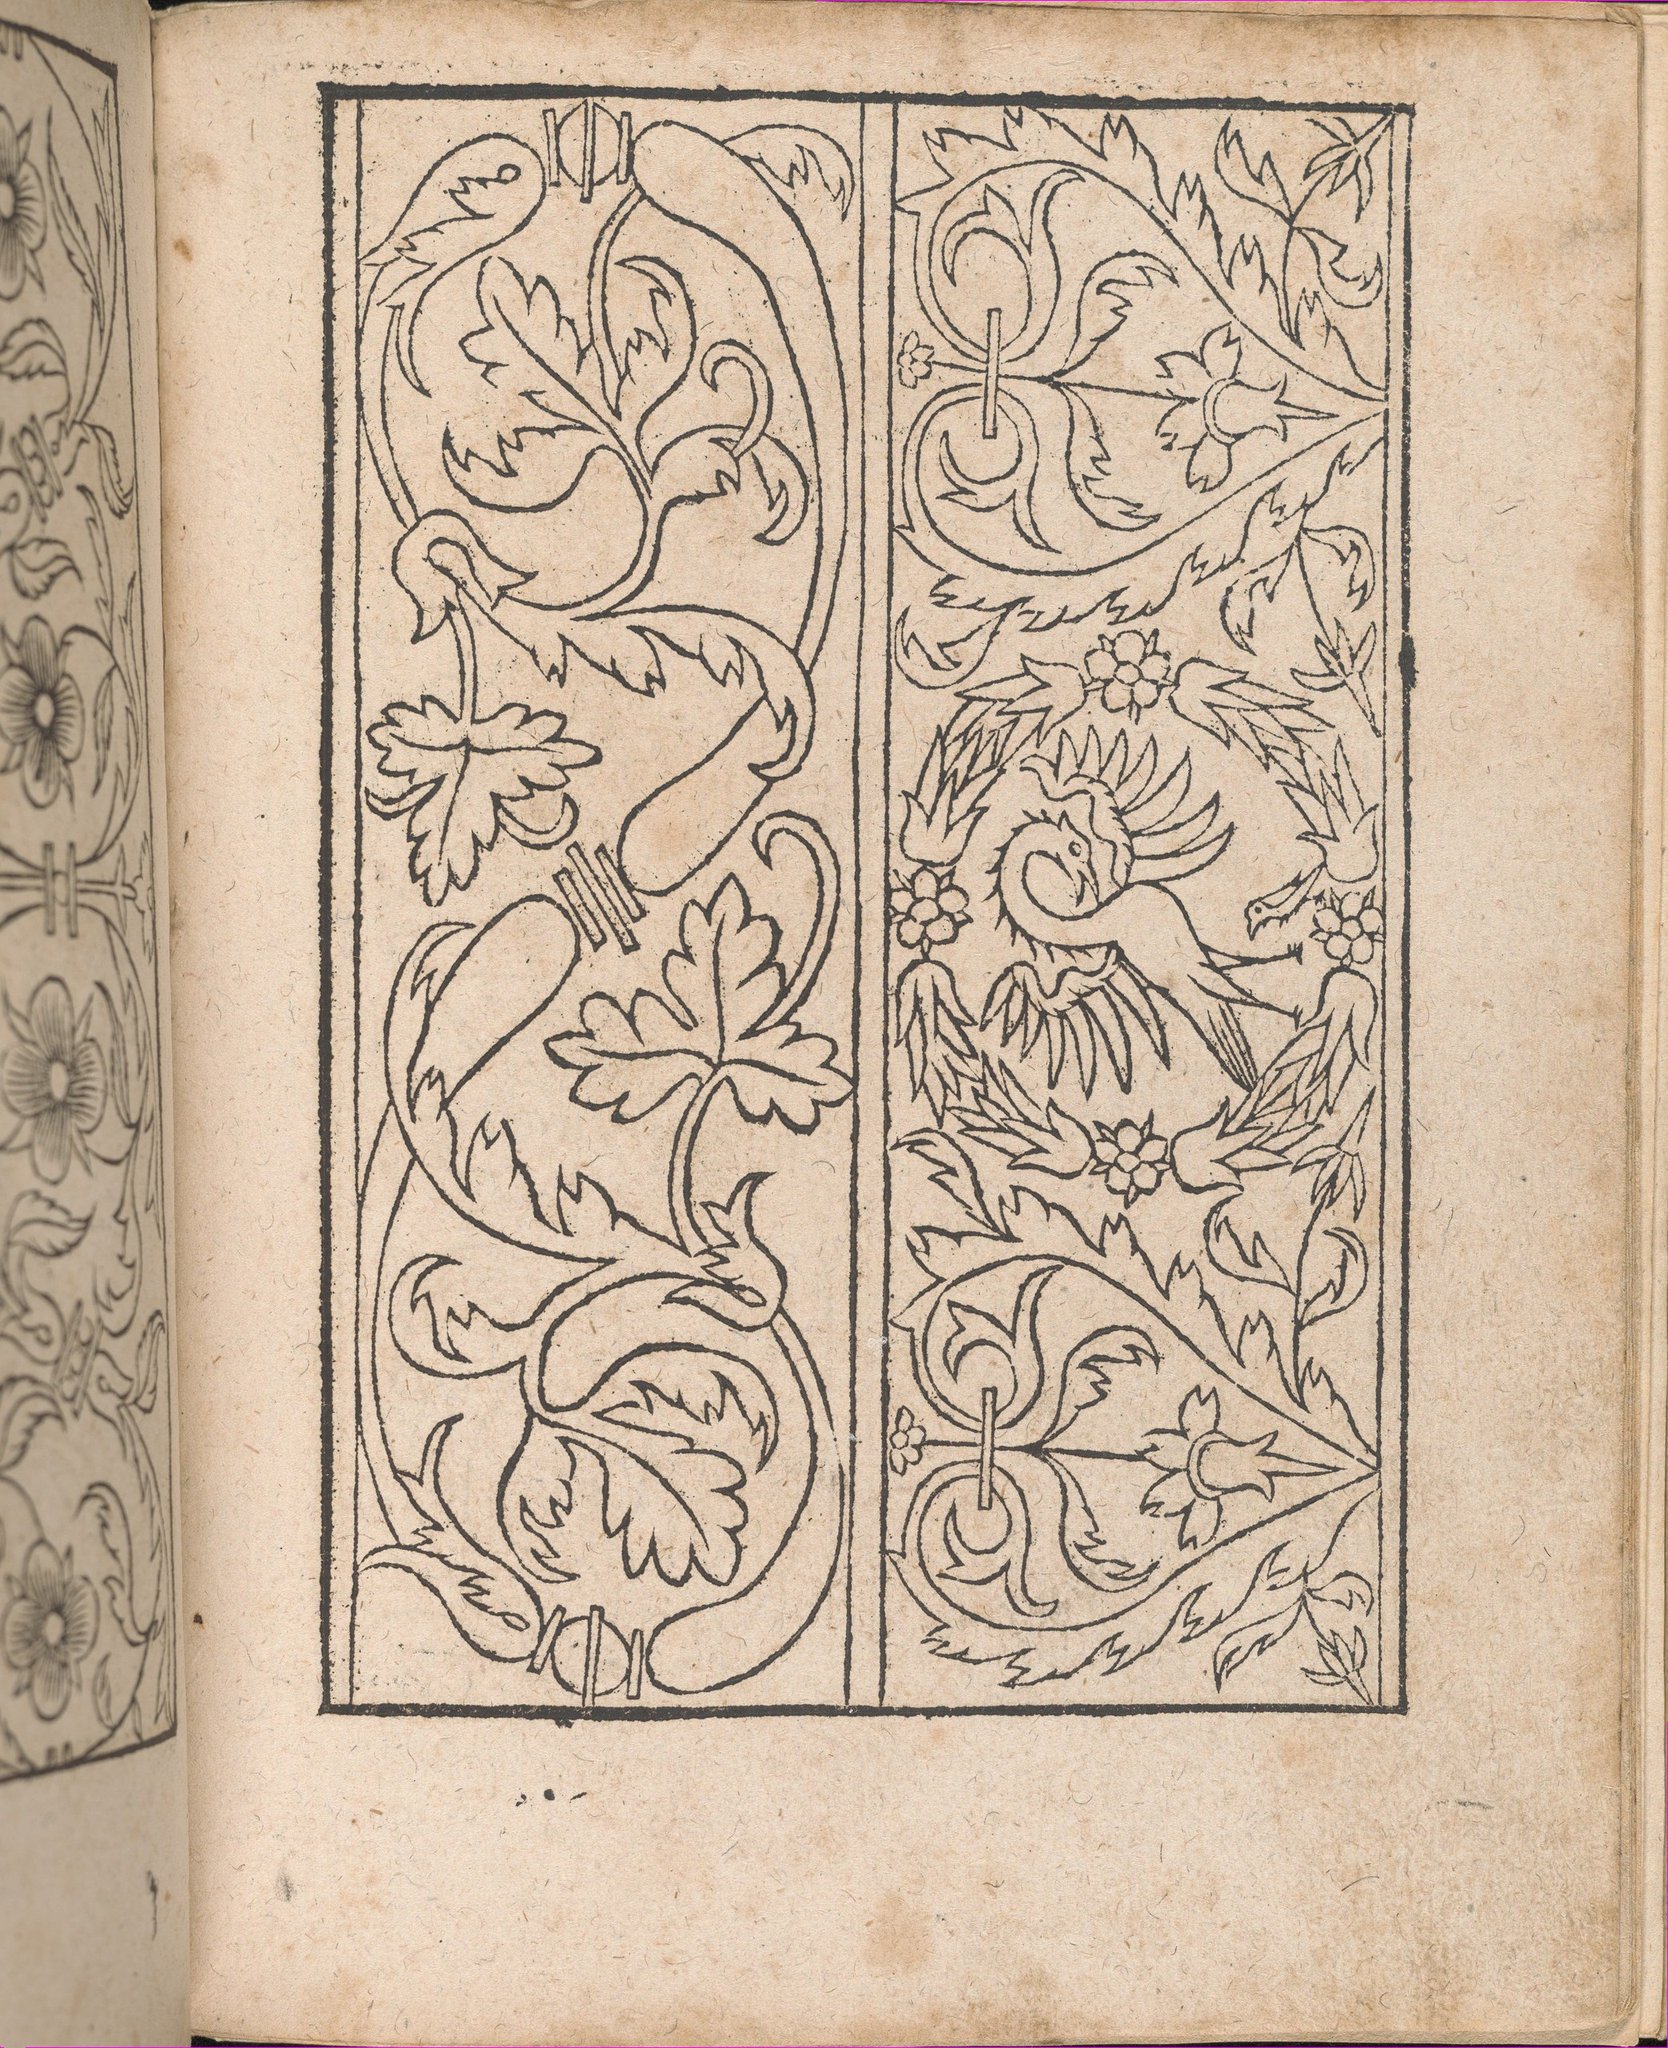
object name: book print ornament architecture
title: New Modelbüch allen Nägerin u. Sydenstickern (Page 24r)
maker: hans hoffman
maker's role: designer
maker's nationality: german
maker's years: 1556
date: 1556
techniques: woodcut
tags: birds